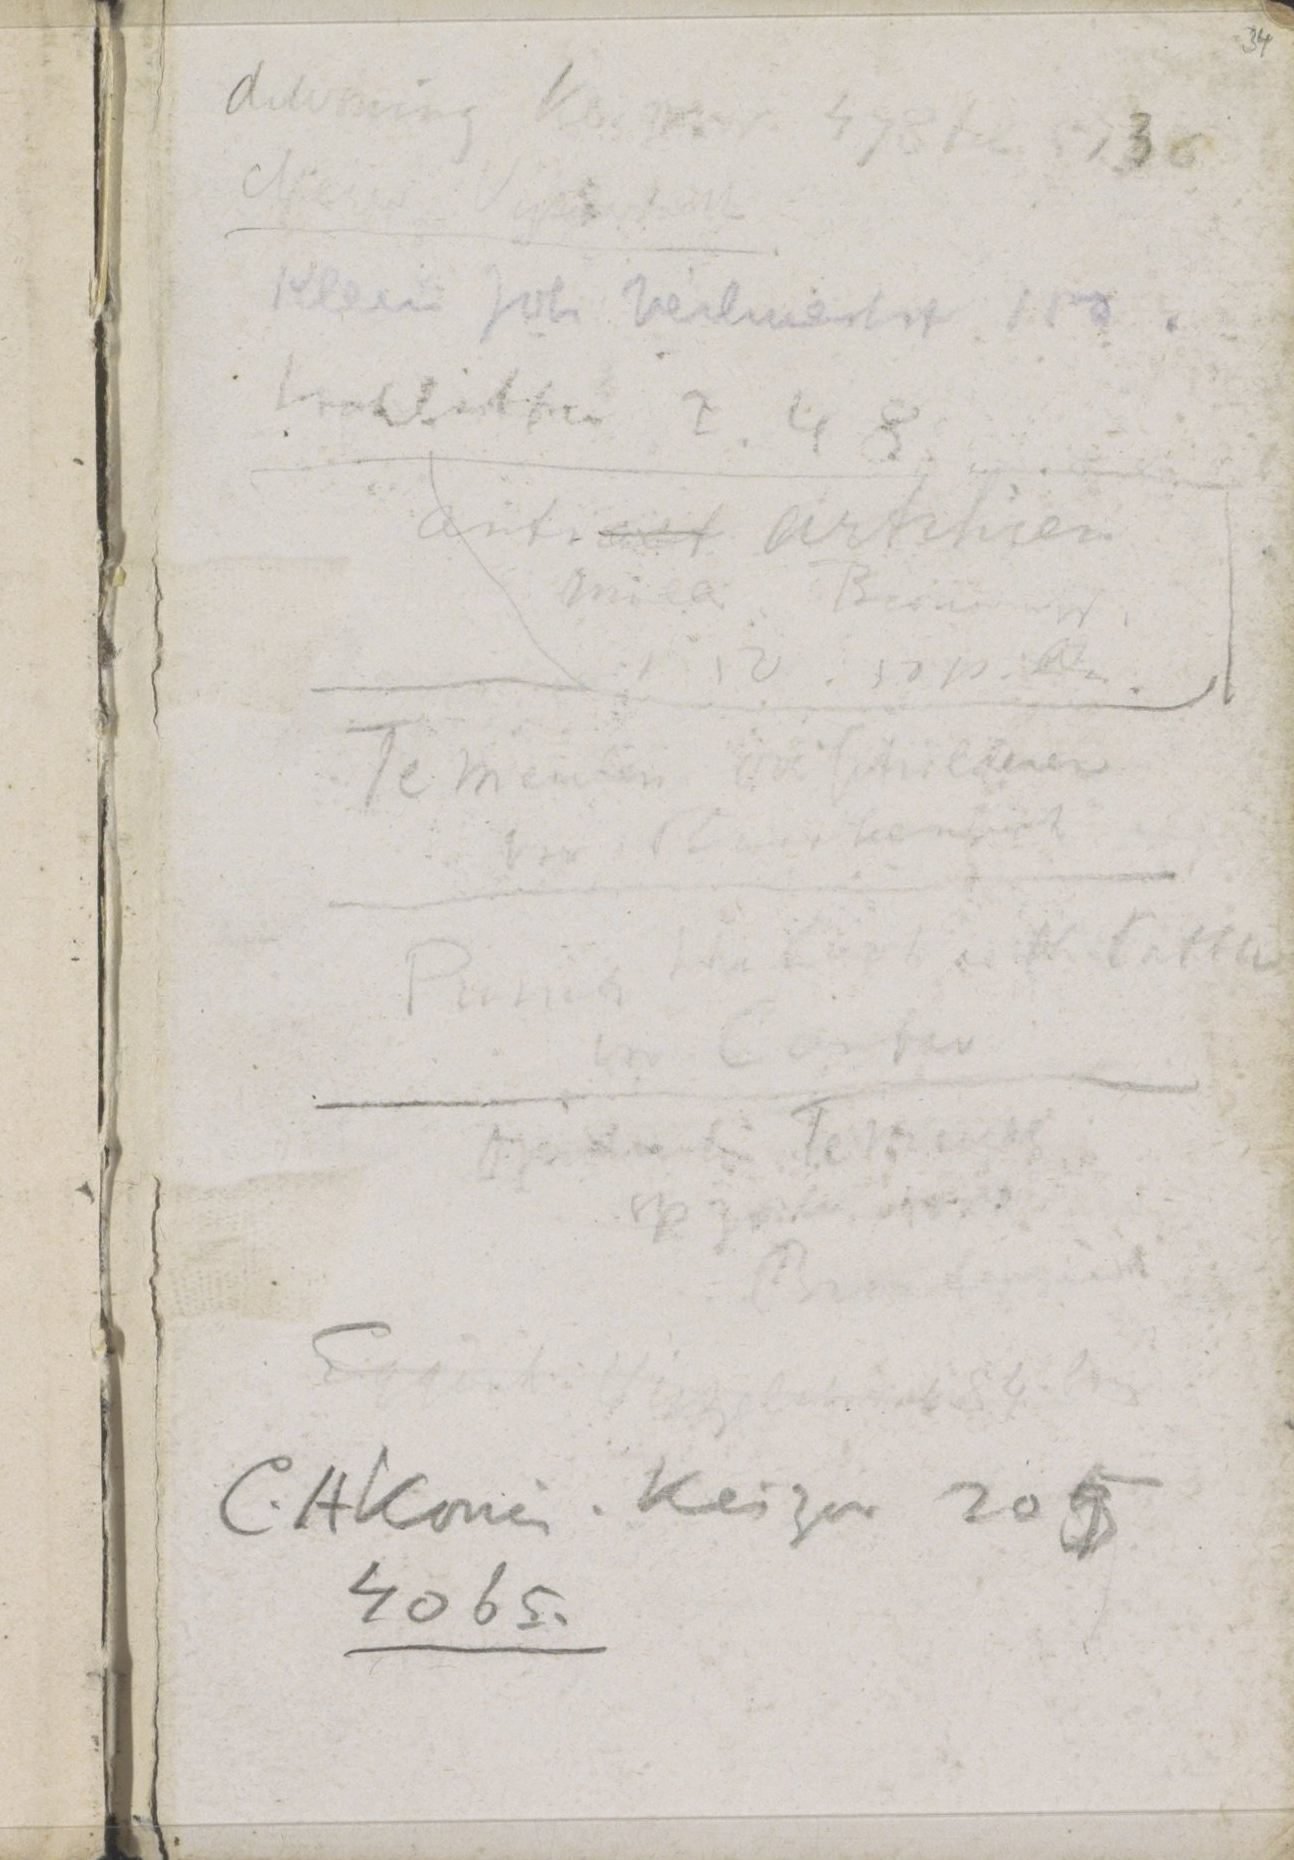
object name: sketchbook leaf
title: Annotaties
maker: george hendrik breitner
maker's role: draughtsman, painter, print maker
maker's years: 1857-1923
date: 1912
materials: paper, pencil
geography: amsterdam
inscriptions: annotation: ‘[...]/ C.H Ko[...]. Keizer 205/ 4065.’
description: Pagina 34, achterste schutblad, uit een schetsboek met 16 bladen.